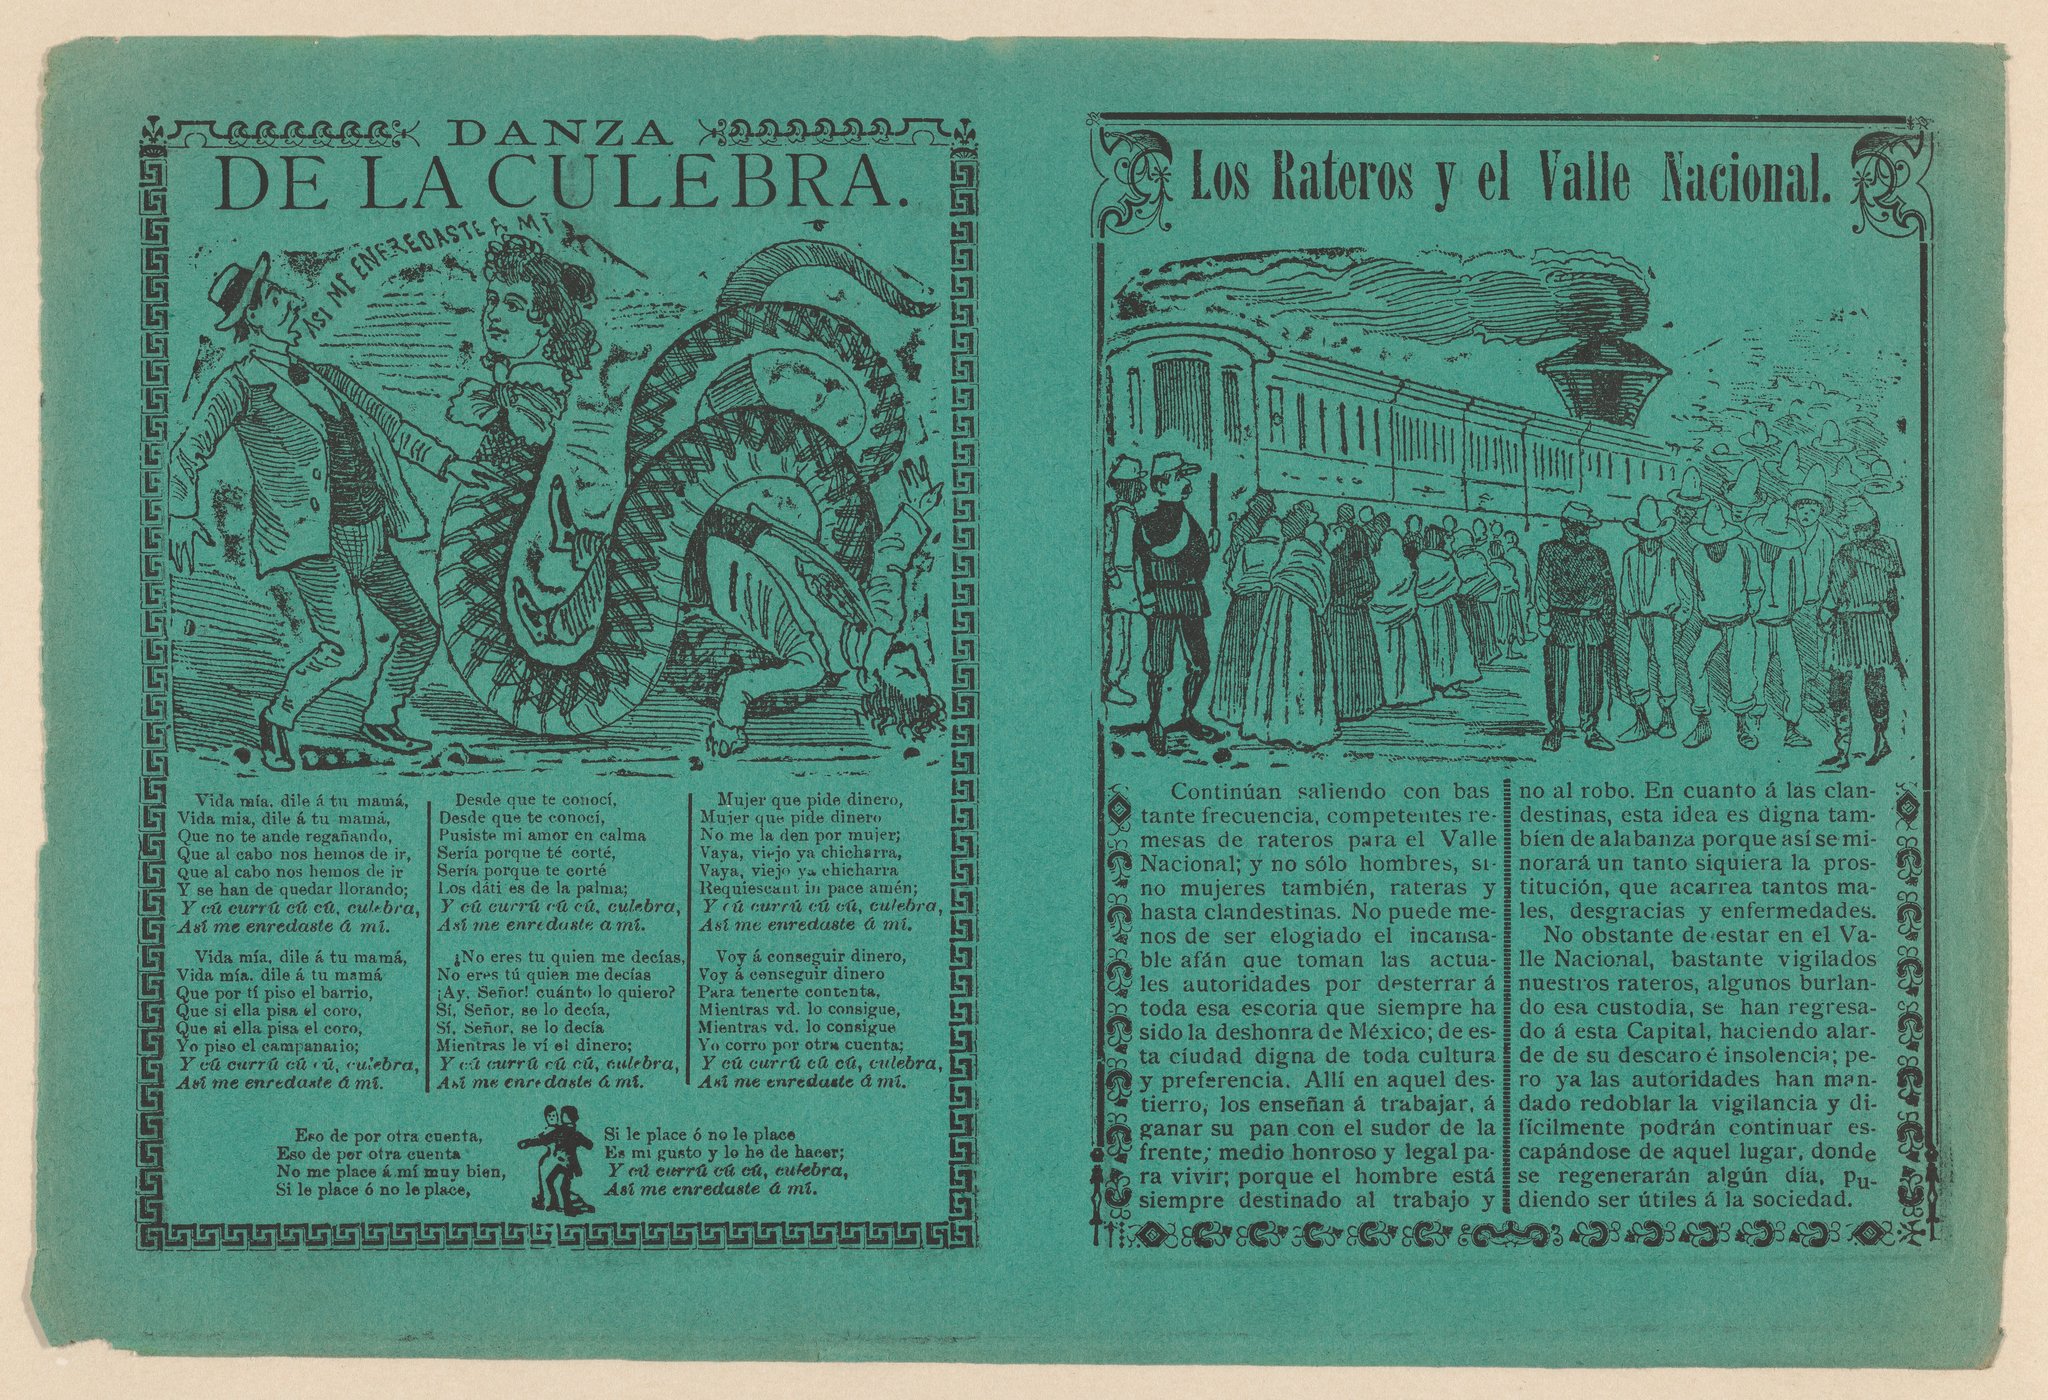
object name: print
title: Front and back covers of a phamplet relating to the story 'The thieves and the National Valley' with illustration of Indigenous men and women being herded by men in military uniforms towards a train, on the verso 'Dance of the Snake' and a corrido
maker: josé guadalupe posada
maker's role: artist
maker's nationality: mexican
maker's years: 1852-1913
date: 1899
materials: paper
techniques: letterpress, lithography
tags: men,women